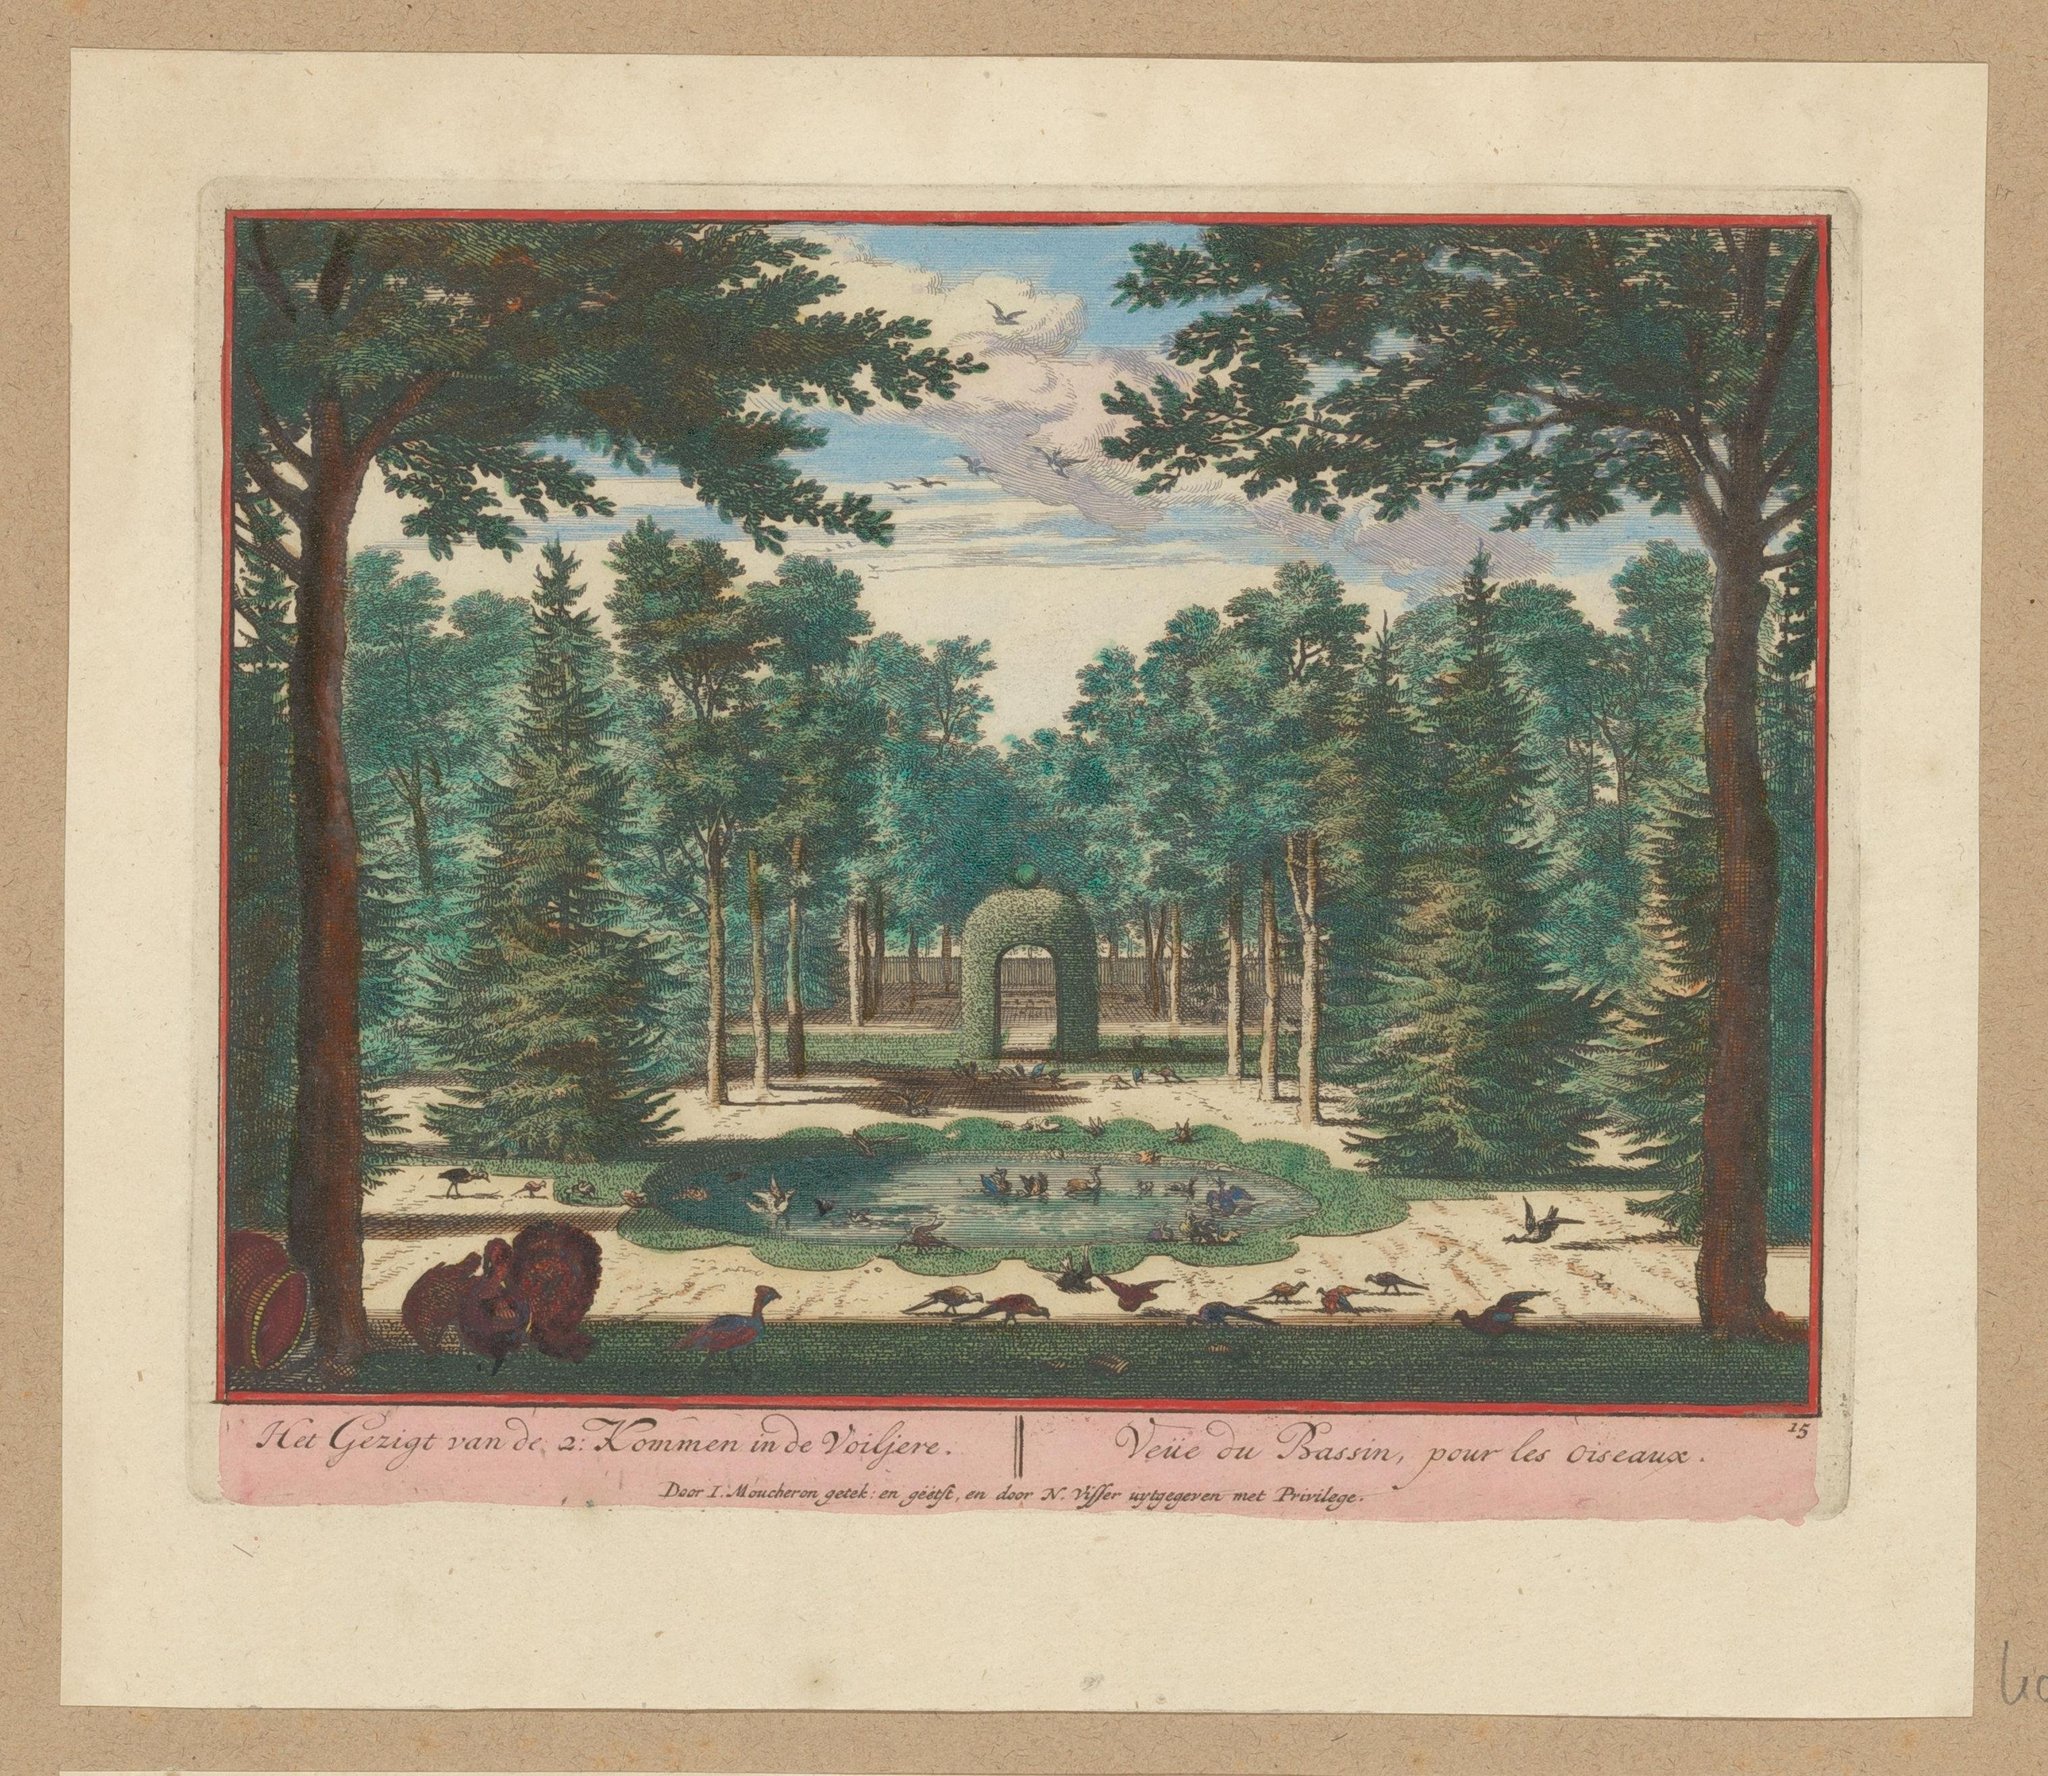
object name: print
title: Eendenvijver van Kasteel Heemstede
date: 1706-1719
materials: paper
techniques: engraving, etching, hand coloring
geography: amsterdam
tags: bird's eye view ~ architectural design or model, garden pond, water-birds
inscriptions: stamp, stamp, stamp, collector's mark: Lugt 1641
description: De eendenvijver op het landgoed van Kasteel Heemstede. Rechtsonder genummerd: 15. Onderwerpsrubrieken binnen de Atlas Zeden en Gewoonten: Zeden en Gewoonten in Engeren Zin, De Woning, Oude Nederlandsche Tuinkunst, De 17de en 18de eeuw. Stadtuinen.